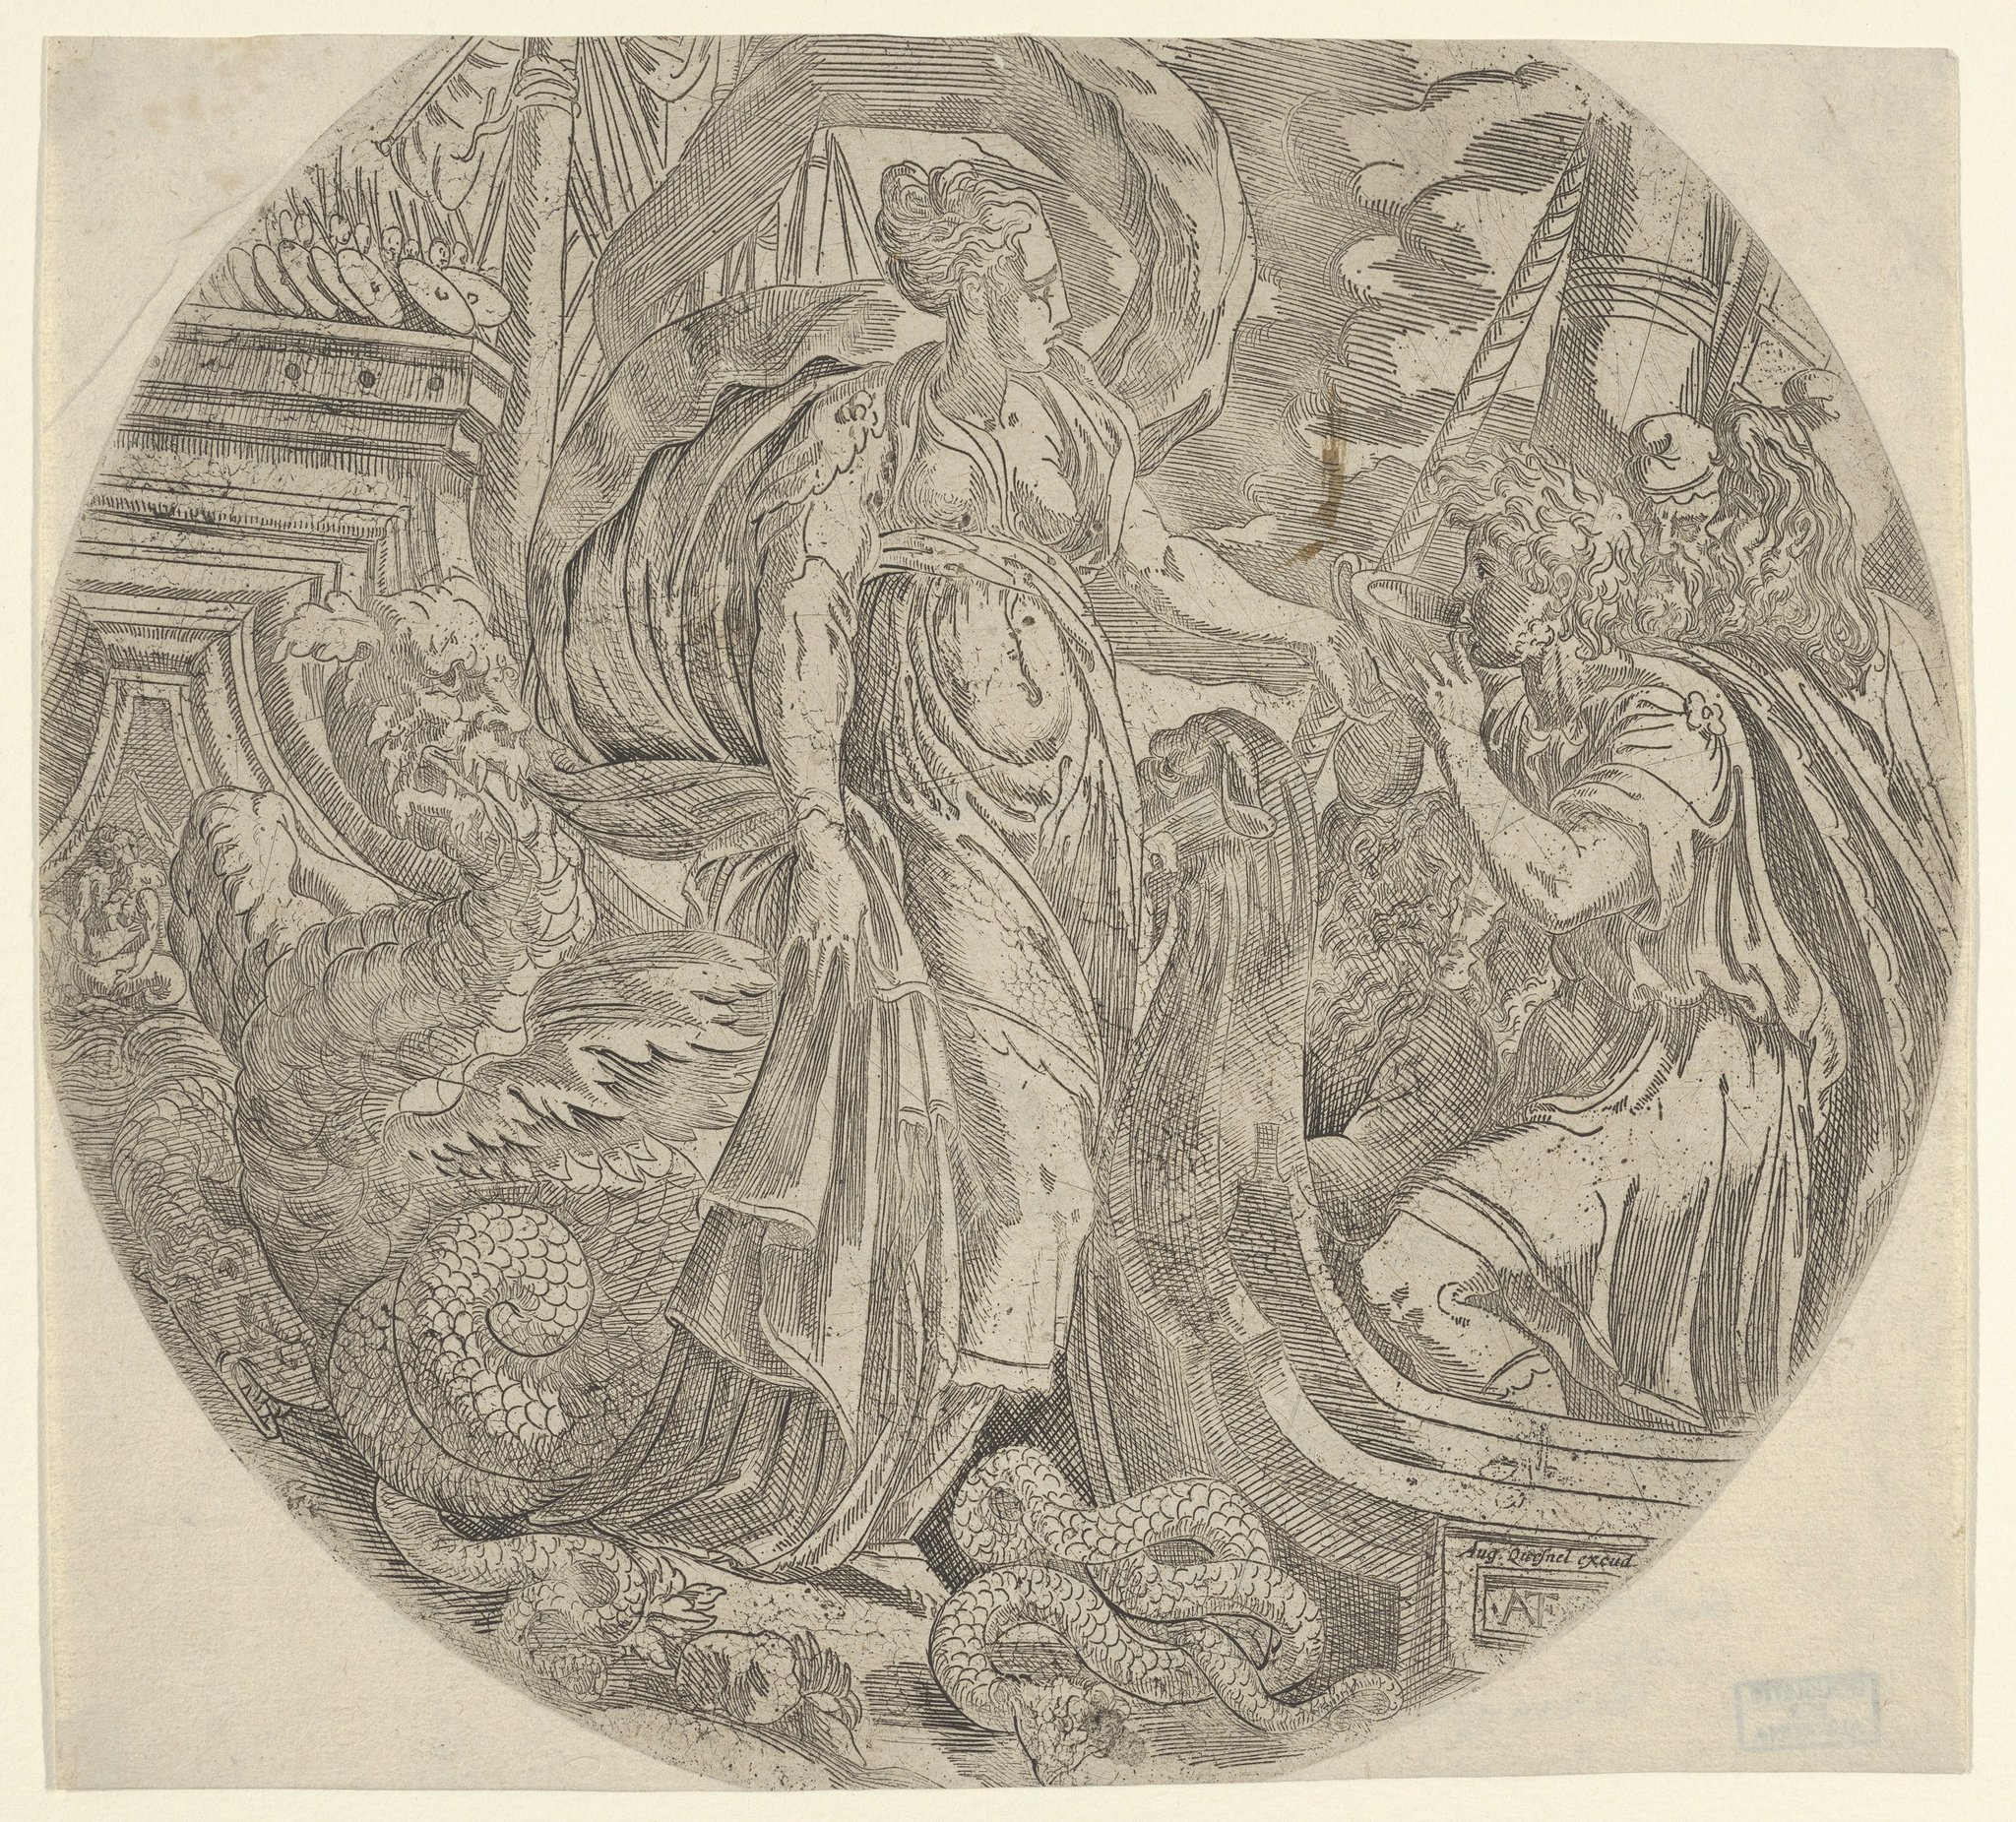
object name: print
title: Circe Giving a Drink to Ulysses's Companions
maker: antonio fantuzzi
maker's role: artist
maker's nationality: italian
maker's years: 1537-1545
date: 1540-1545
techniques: etching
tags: men,women,drinking,boats